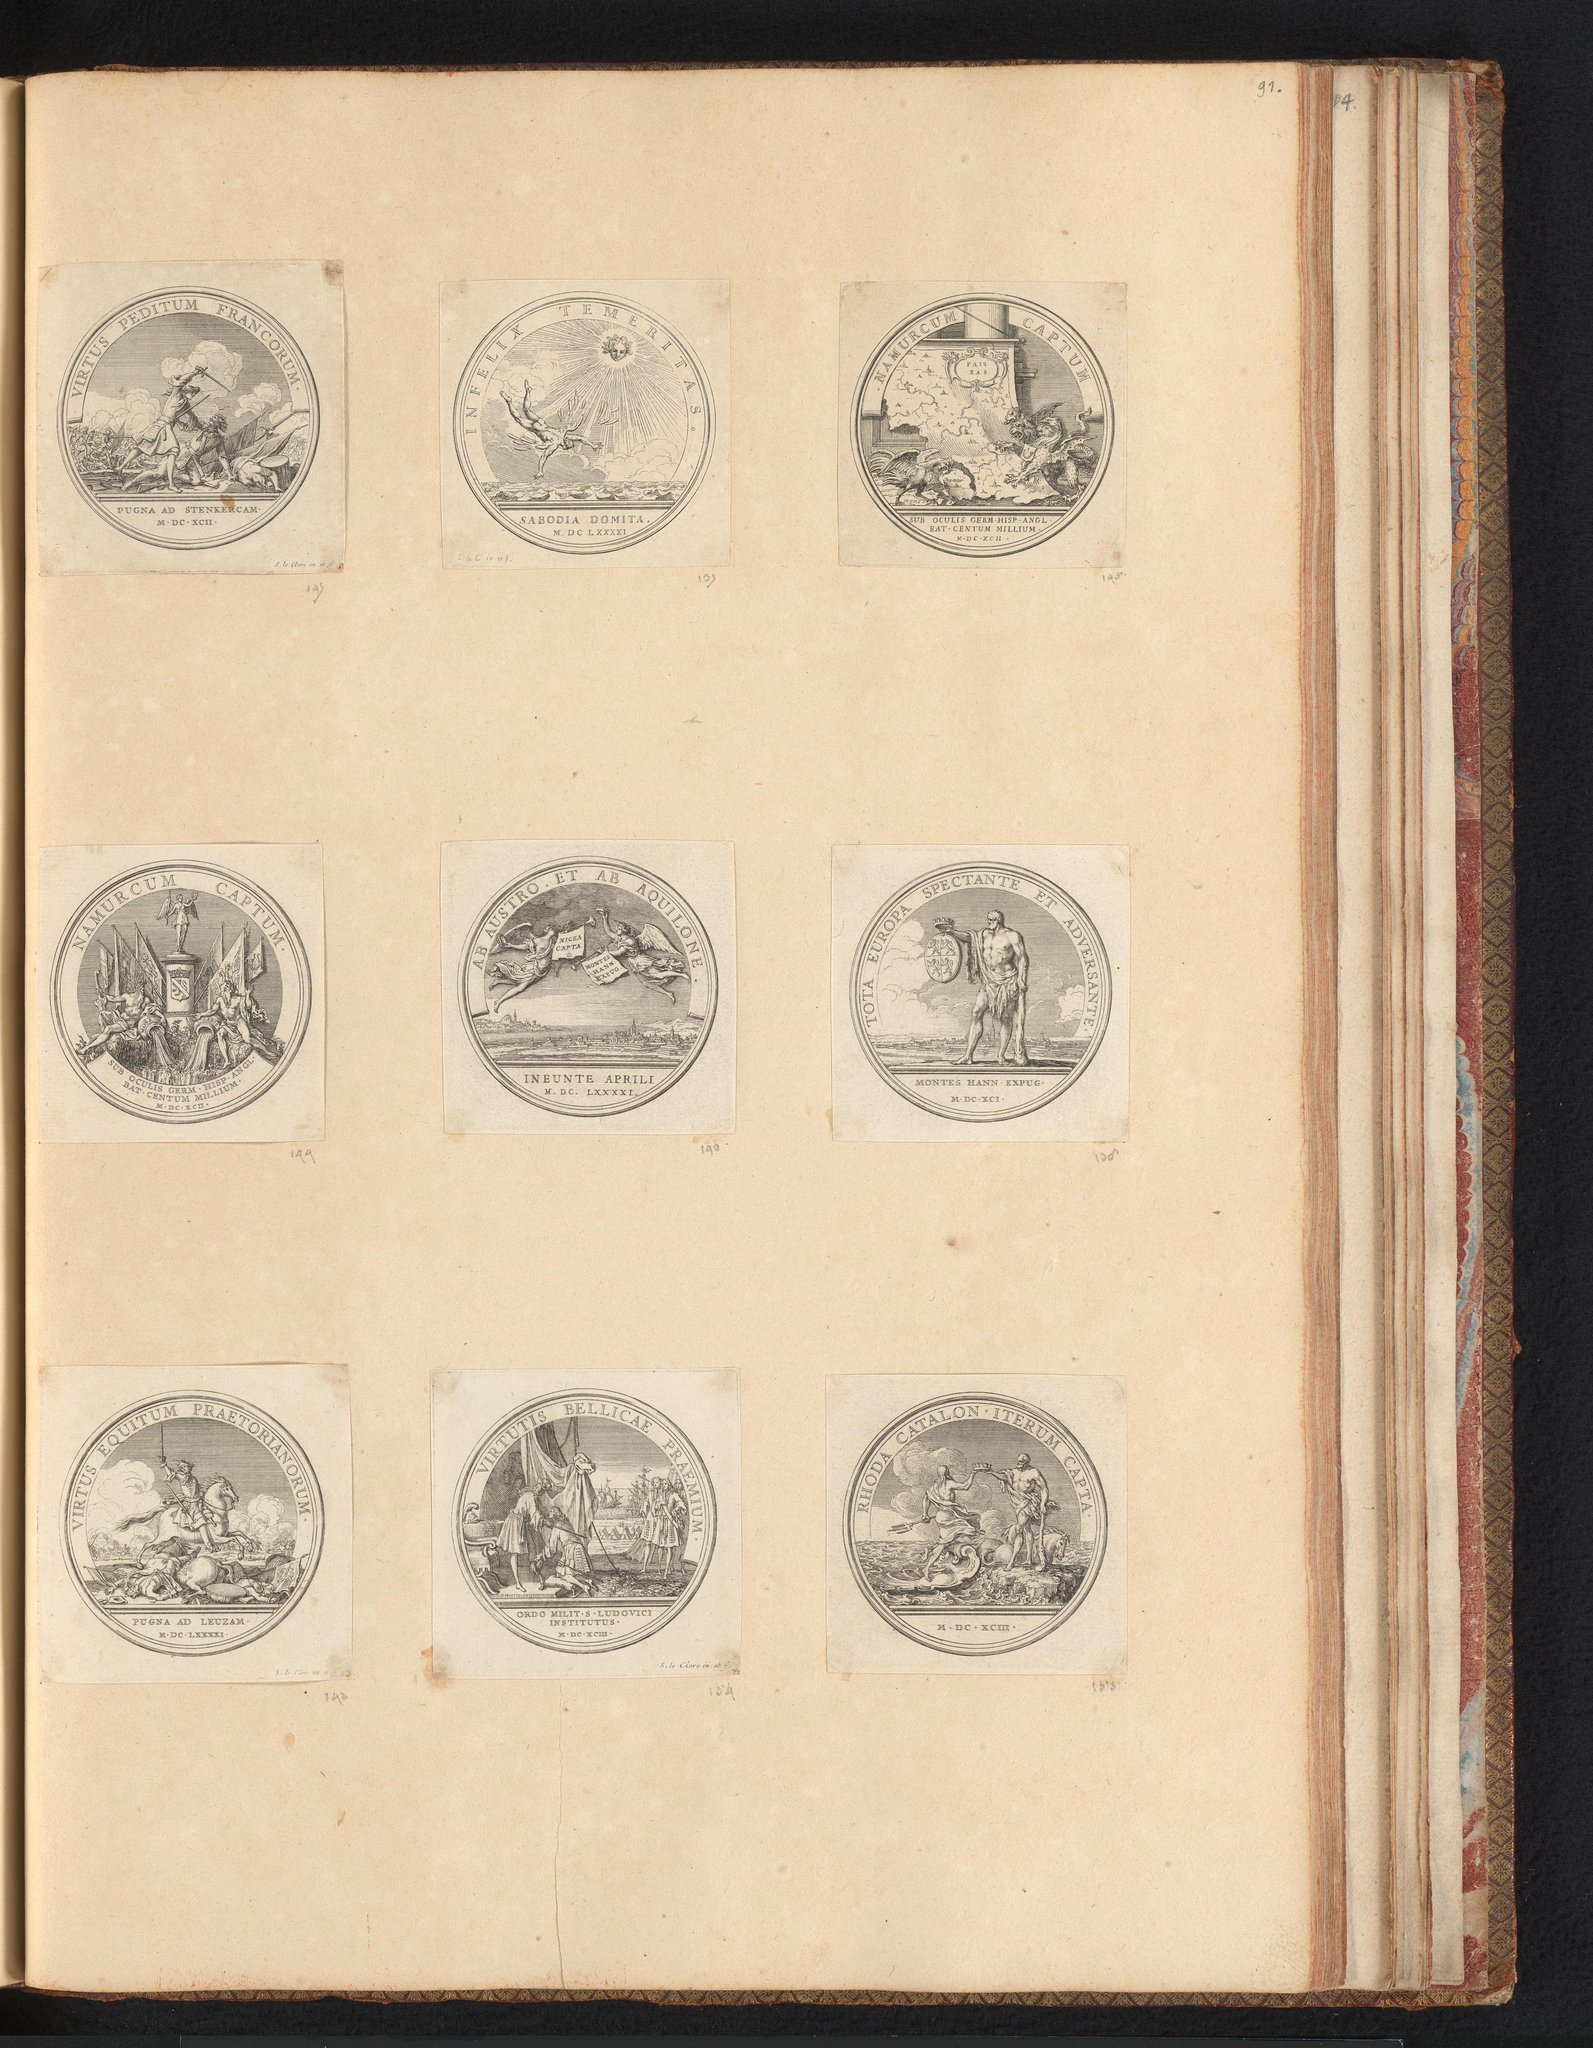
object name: book illustration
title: Negen medailles ter ere van Lodewijk XIV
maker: sébastien leclerc (i)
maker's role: print maker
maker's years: 1637-1714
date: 1702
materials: paper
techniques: etching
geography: paris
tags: lodewijk xiv (koning van frankrijk), (story of) neptune (poseidon), (story of) hercules (heracles), death i.e. the fall of icarus (daedalus present), historical persons, battle, medal (considered as a piece of sculpture, regardless of its specific function), fama as roman personification, fame; 'fama', 'fama buona', 'fama chiara' (ripa), king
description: Prenten bestemd voor: Médailles sur les principaux événements du règne de Louis le Grand. Parijs: Imprimerie Royale, 1702. Drie prenten niet gepubliceerd.